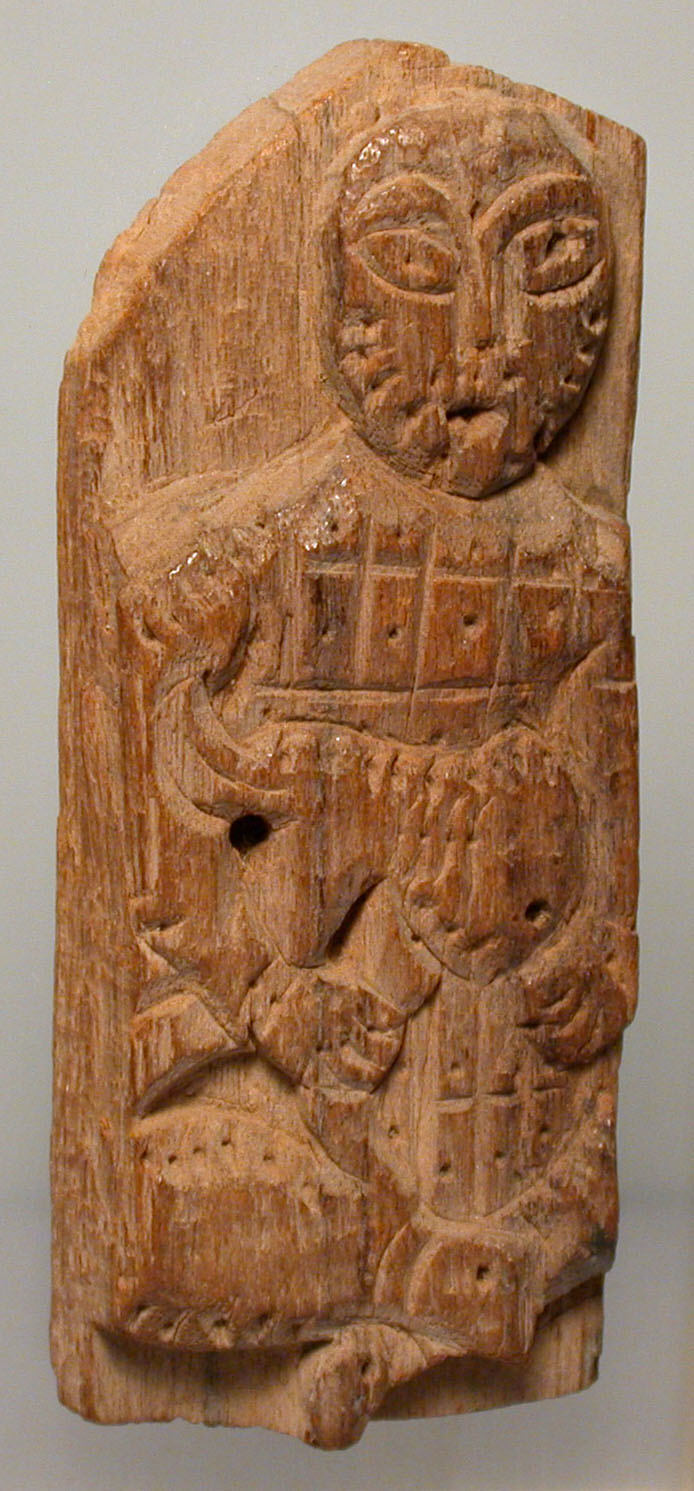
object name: plaque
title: Plaque of a Man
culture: byzantine or roman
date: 325-641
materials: wood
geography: egypt